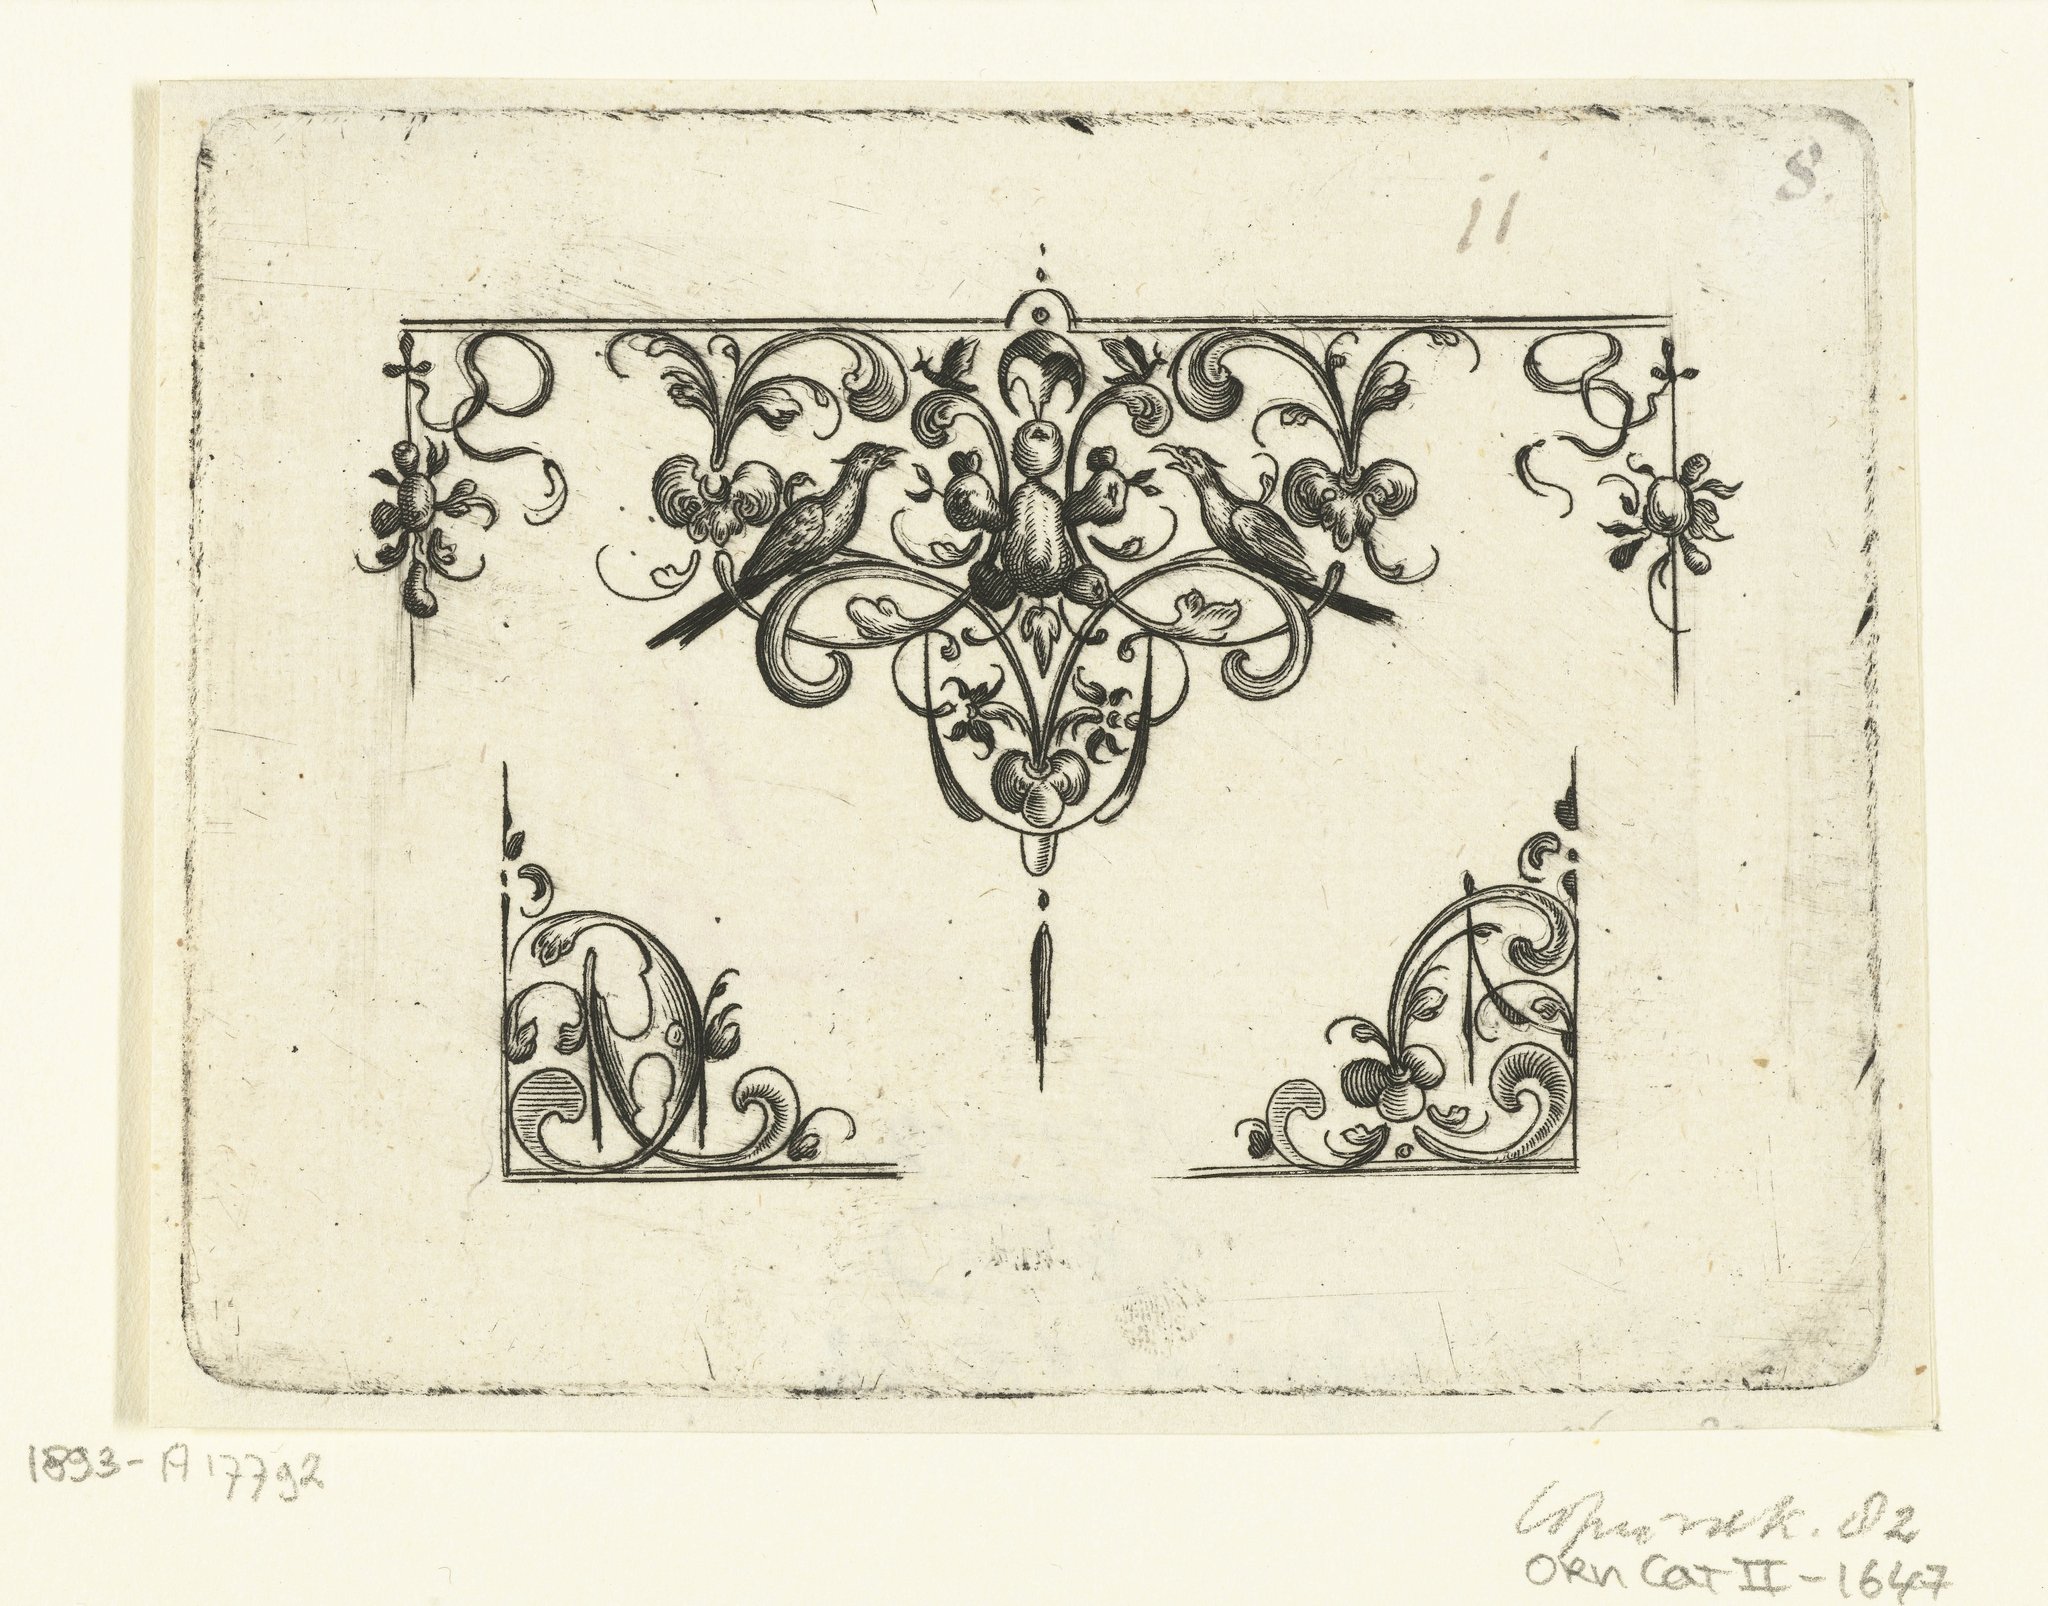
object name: ornament print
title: Somige Eenvoldige Vruchten en Spitsen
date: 1611-1635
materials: paper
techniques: engraving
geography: nuremberg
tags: fantasy ornament, birds, fruits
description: Kopie van serie met dezelfde titel, uitgegeven door Michiel le Blon. Blad 11 uit serie van 14 bladen met voorbeelden voor gegraveerde decoratieranden van bekers in de vorm van driehoeken bestaande uit ranken, Schweifwerk, guirlandes met putti, dieren, vogels en maskers.